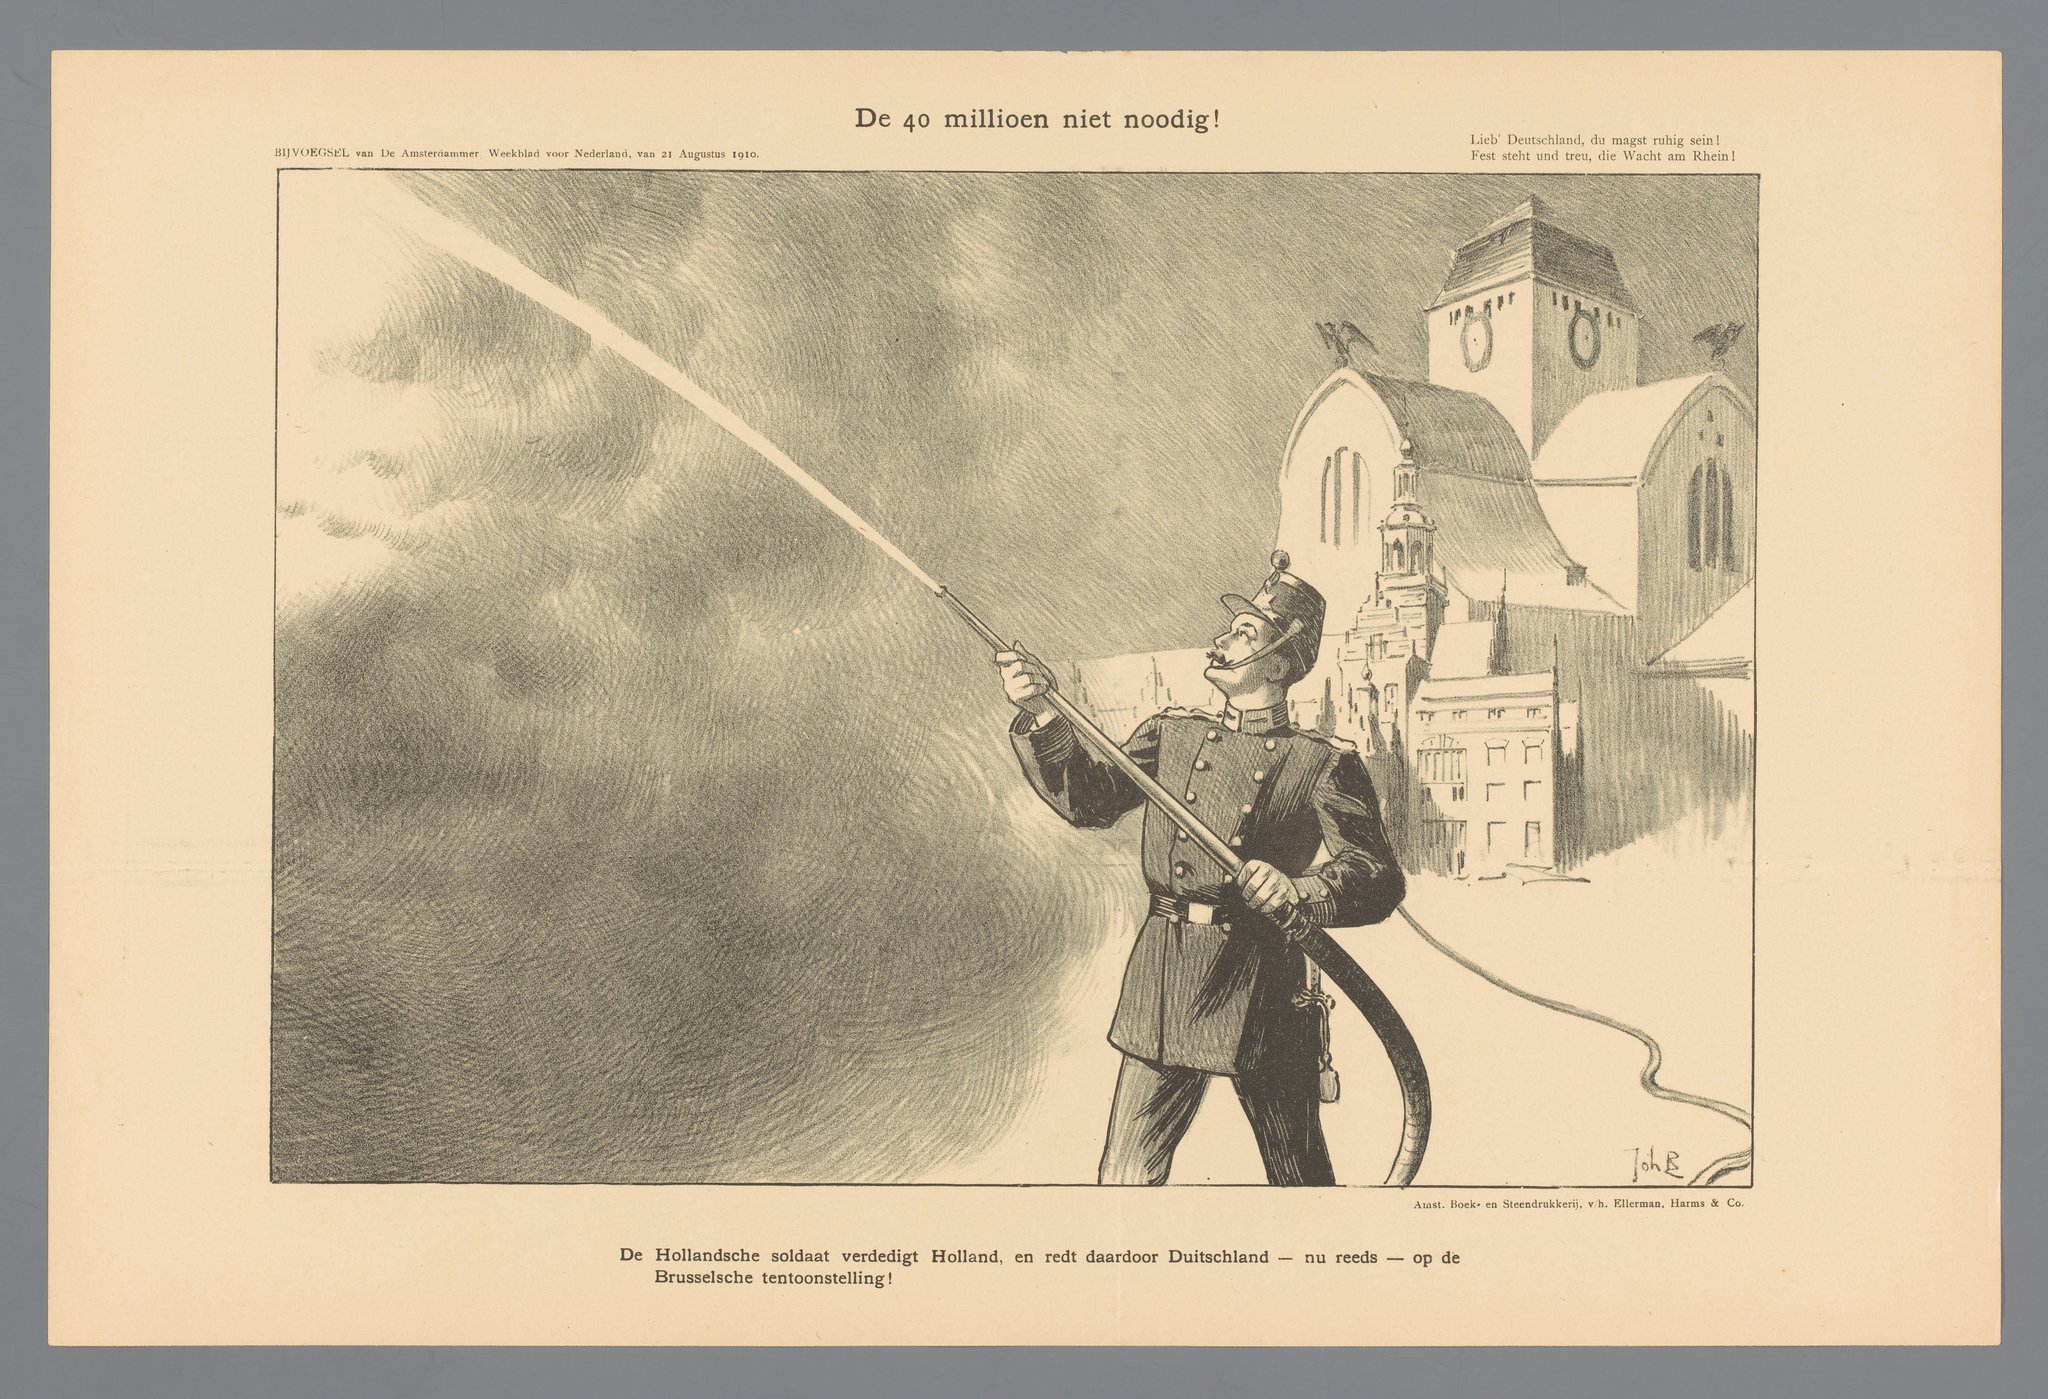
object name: cartoon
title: De 40 millioen niet noodig!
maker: johan braakensiek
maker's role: draughtsman, print maker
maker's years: 1858-1940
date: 1910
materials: paper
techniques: lithograph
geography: amsterdam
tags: the soldier; the soldier's life, firemen, political caricatures and satires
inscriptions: date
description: Prent uit het bijvoegsel van: De Amsterdammer. Weekblad voor Nederland, 21 augustus 1910.